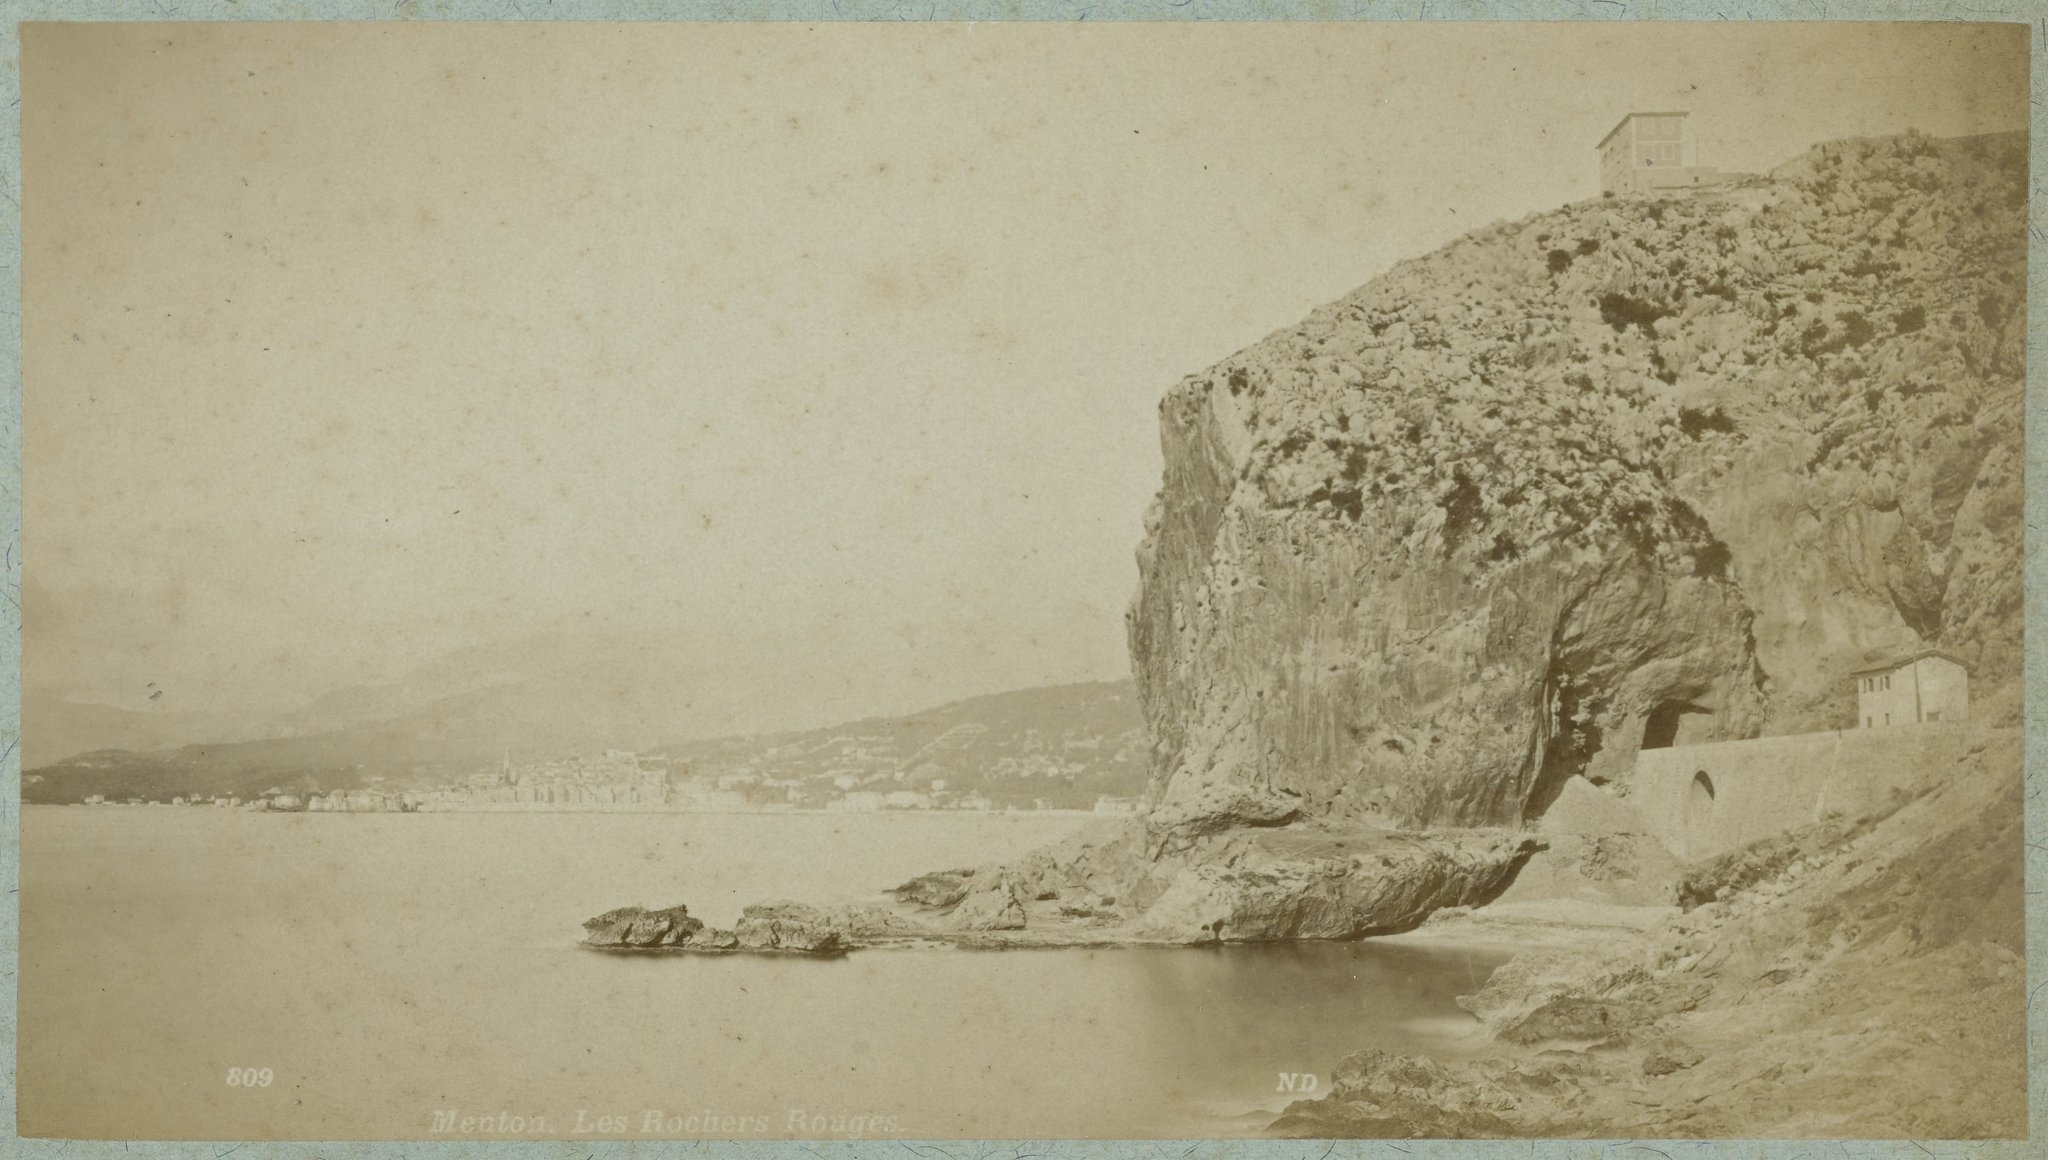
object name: photograph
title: Menton. Les Rochers Rouges.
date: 1863-1891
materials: cardboard, paper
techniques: albumen print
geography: menton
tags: rocky coast, rock-formations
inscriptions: inscription: ‘809/ Menton. Les Rochers Rouges./ ND’